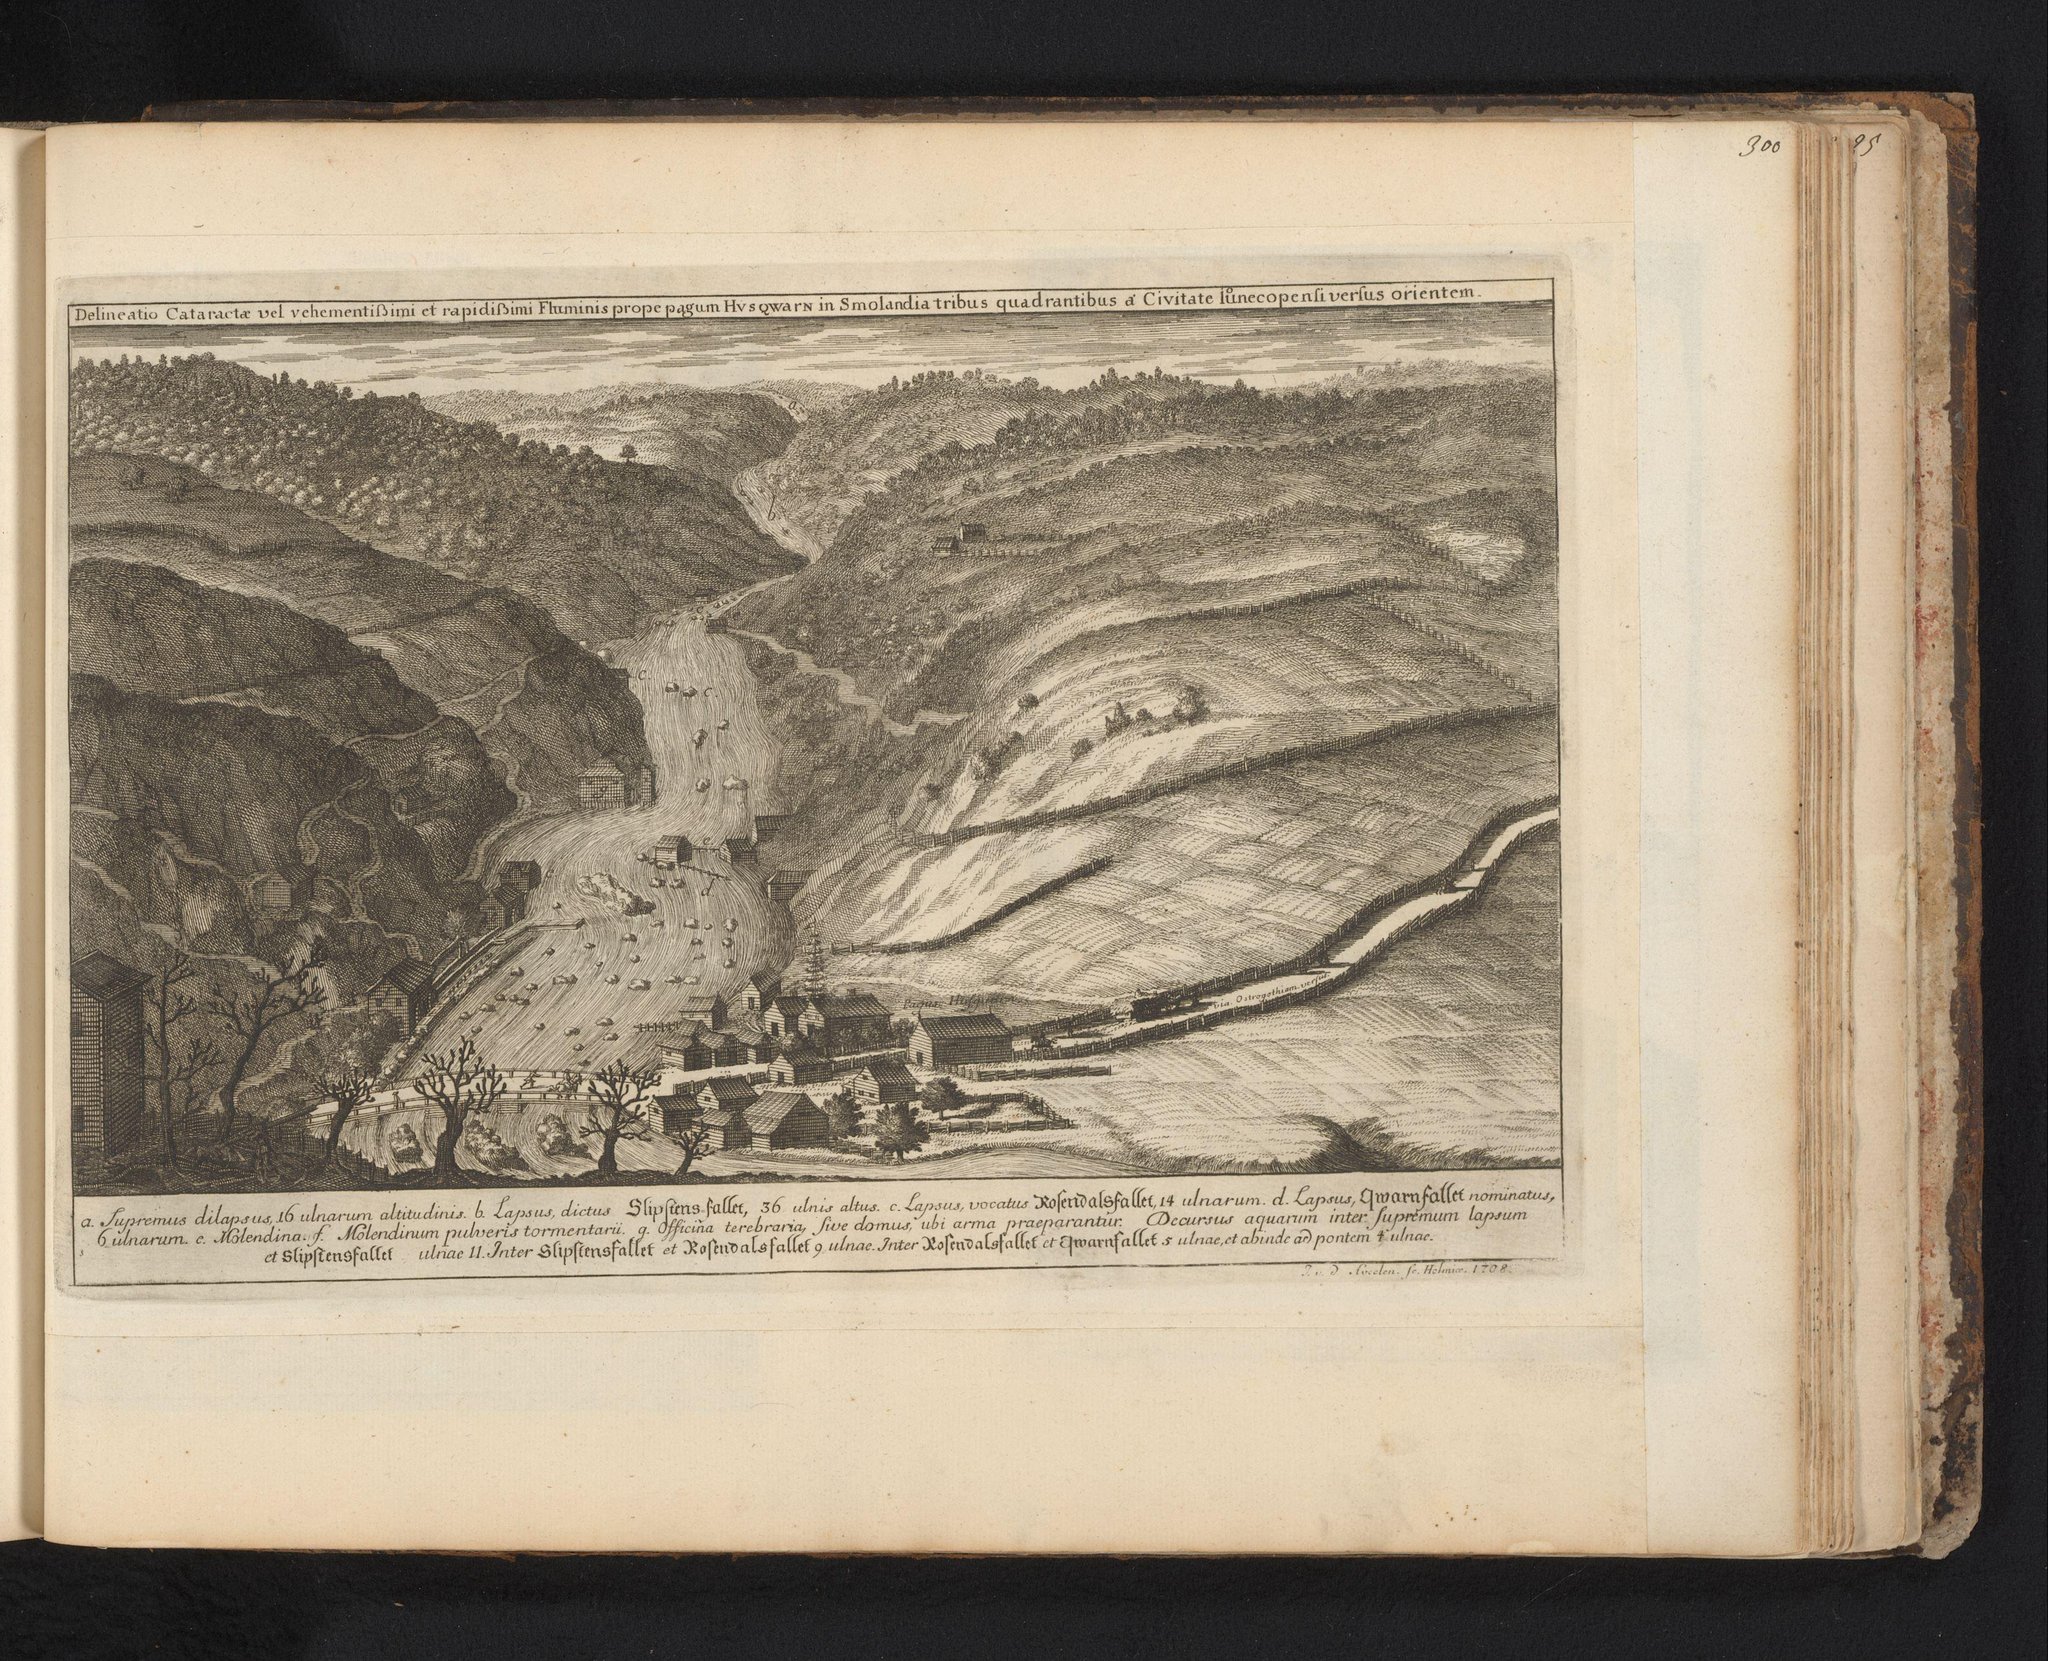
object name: album leaf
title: Gezicht op de watervallen van Huskvarna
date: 1708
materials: paper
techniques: etching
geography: stockholm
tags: waterfall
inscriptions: date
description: Kungliga Biblioteket, 'Suecia': http://www.kb.se/samlingarna/Kartor-bilder/Suecia-antiqua/ (geraadpleegd november 2016).